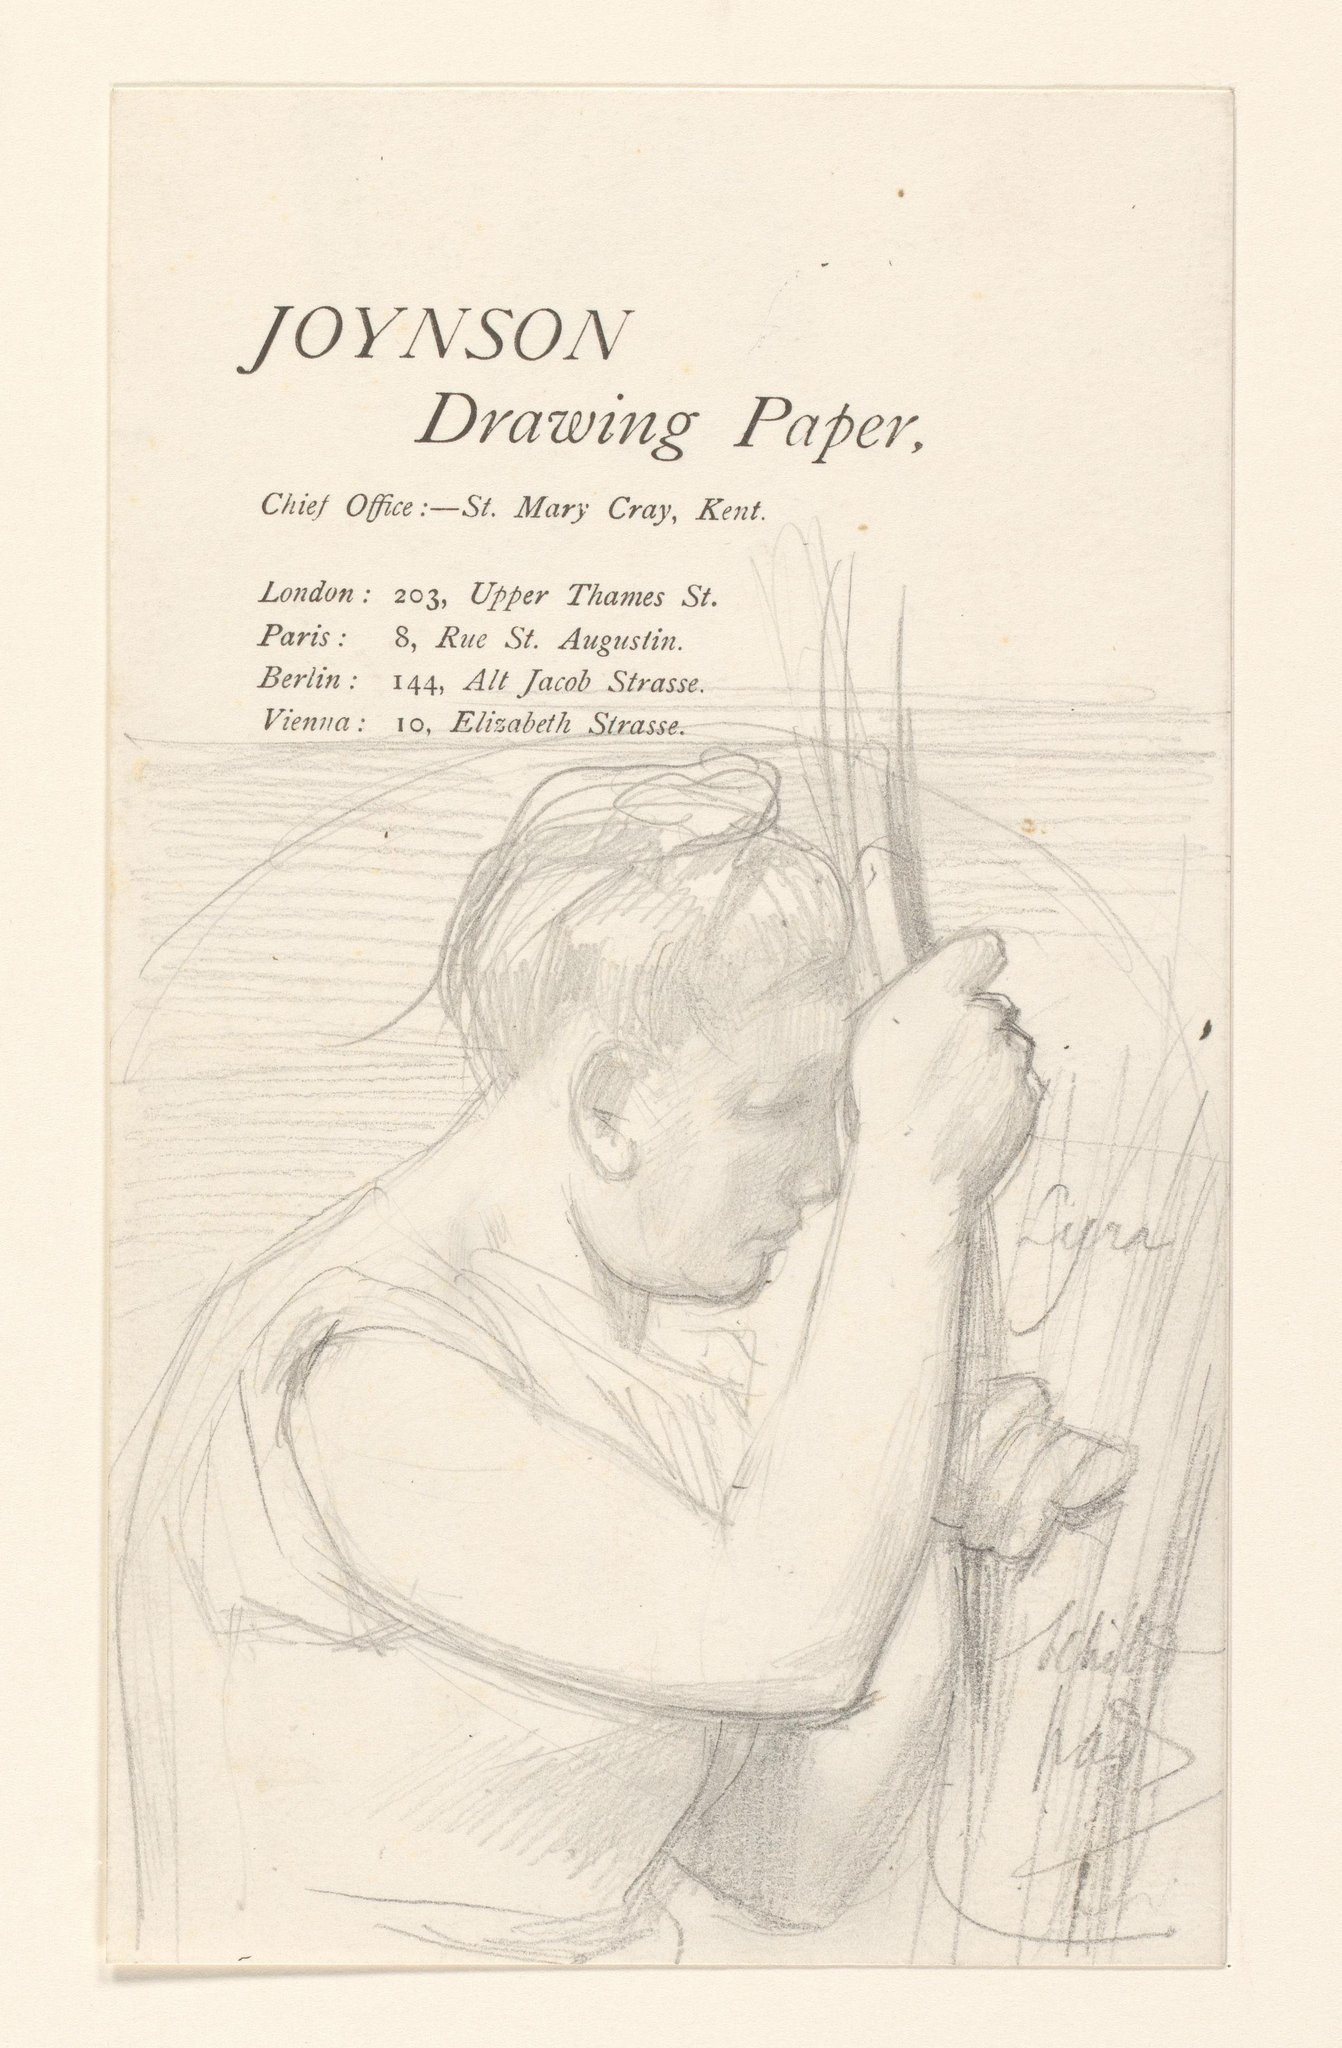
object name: drawing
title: Vrouw met gebruiksvoorwerp in de hand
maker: august allebé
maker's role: draughtsman, print maker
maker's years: 1838-1927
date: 1848-1927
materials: paper, pencil